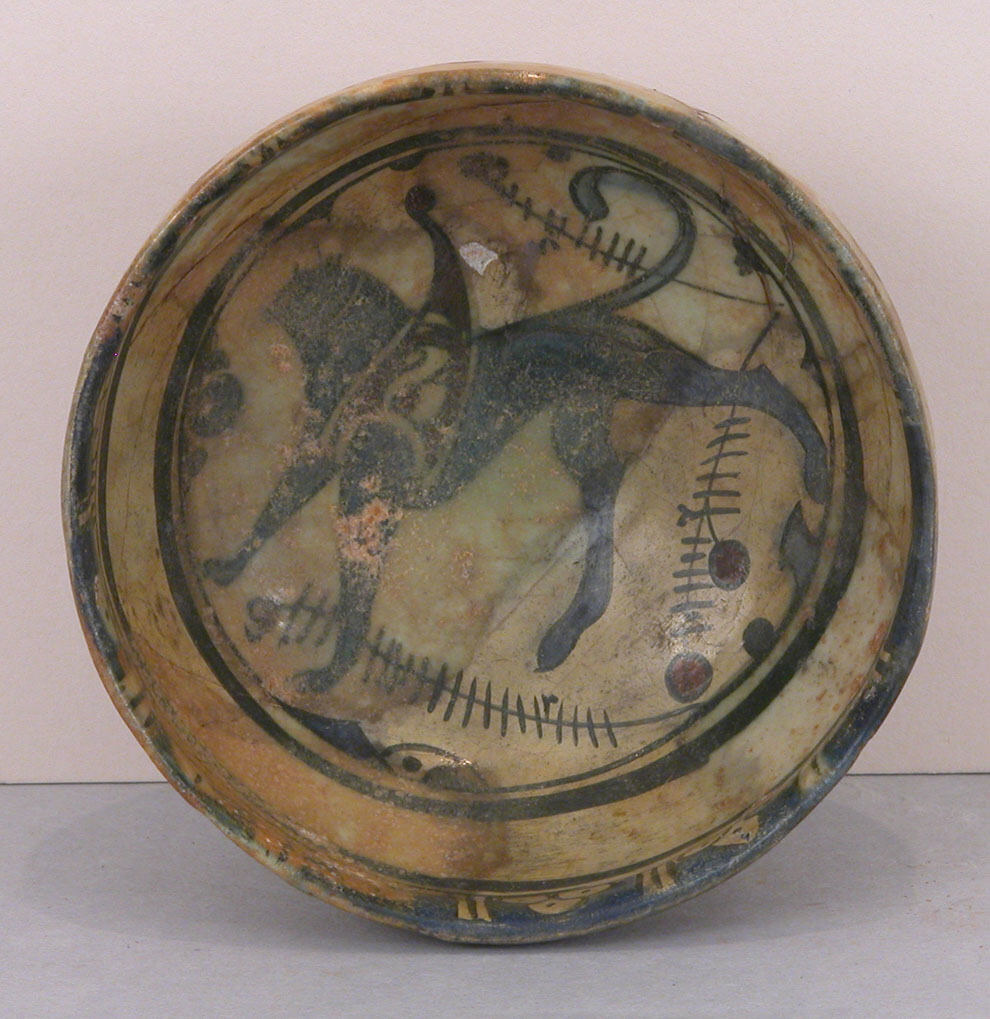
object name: bowl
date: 1101-1300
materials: stonepaste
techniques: painting, underglaze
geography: syria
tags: animals